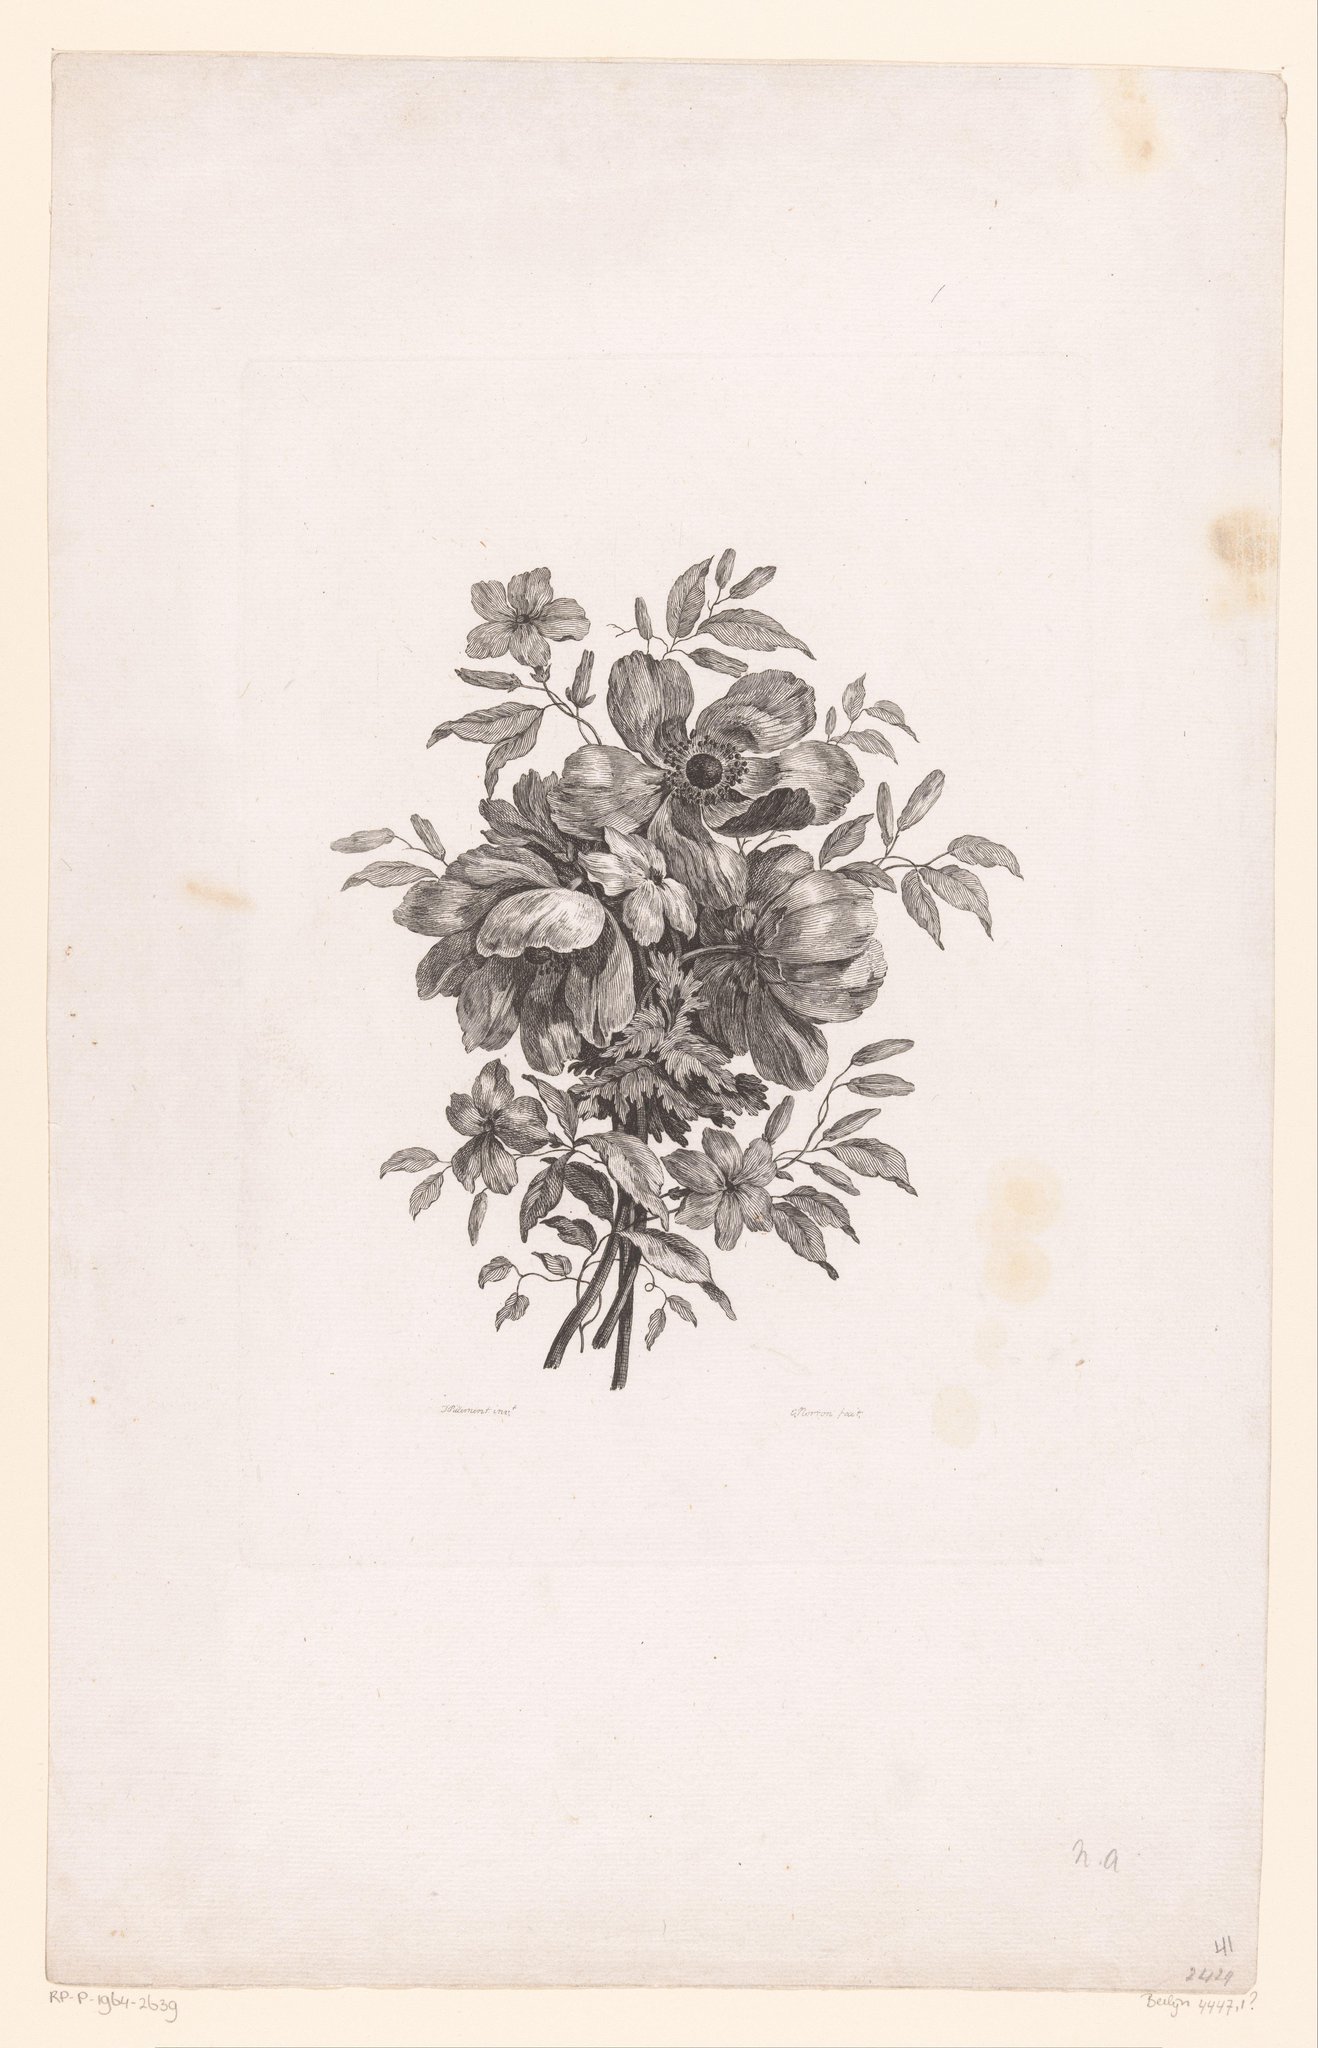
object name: ornament print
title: Boeket met klaprozen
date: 1760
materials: paper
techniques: etching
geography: london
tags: cut flowers; nosegay, bunch of flowers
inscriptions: collector's mark: Lugt 2760, collector's mark: Lugt 2228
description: Prent is onderdeel van een serie van zes of zeven.